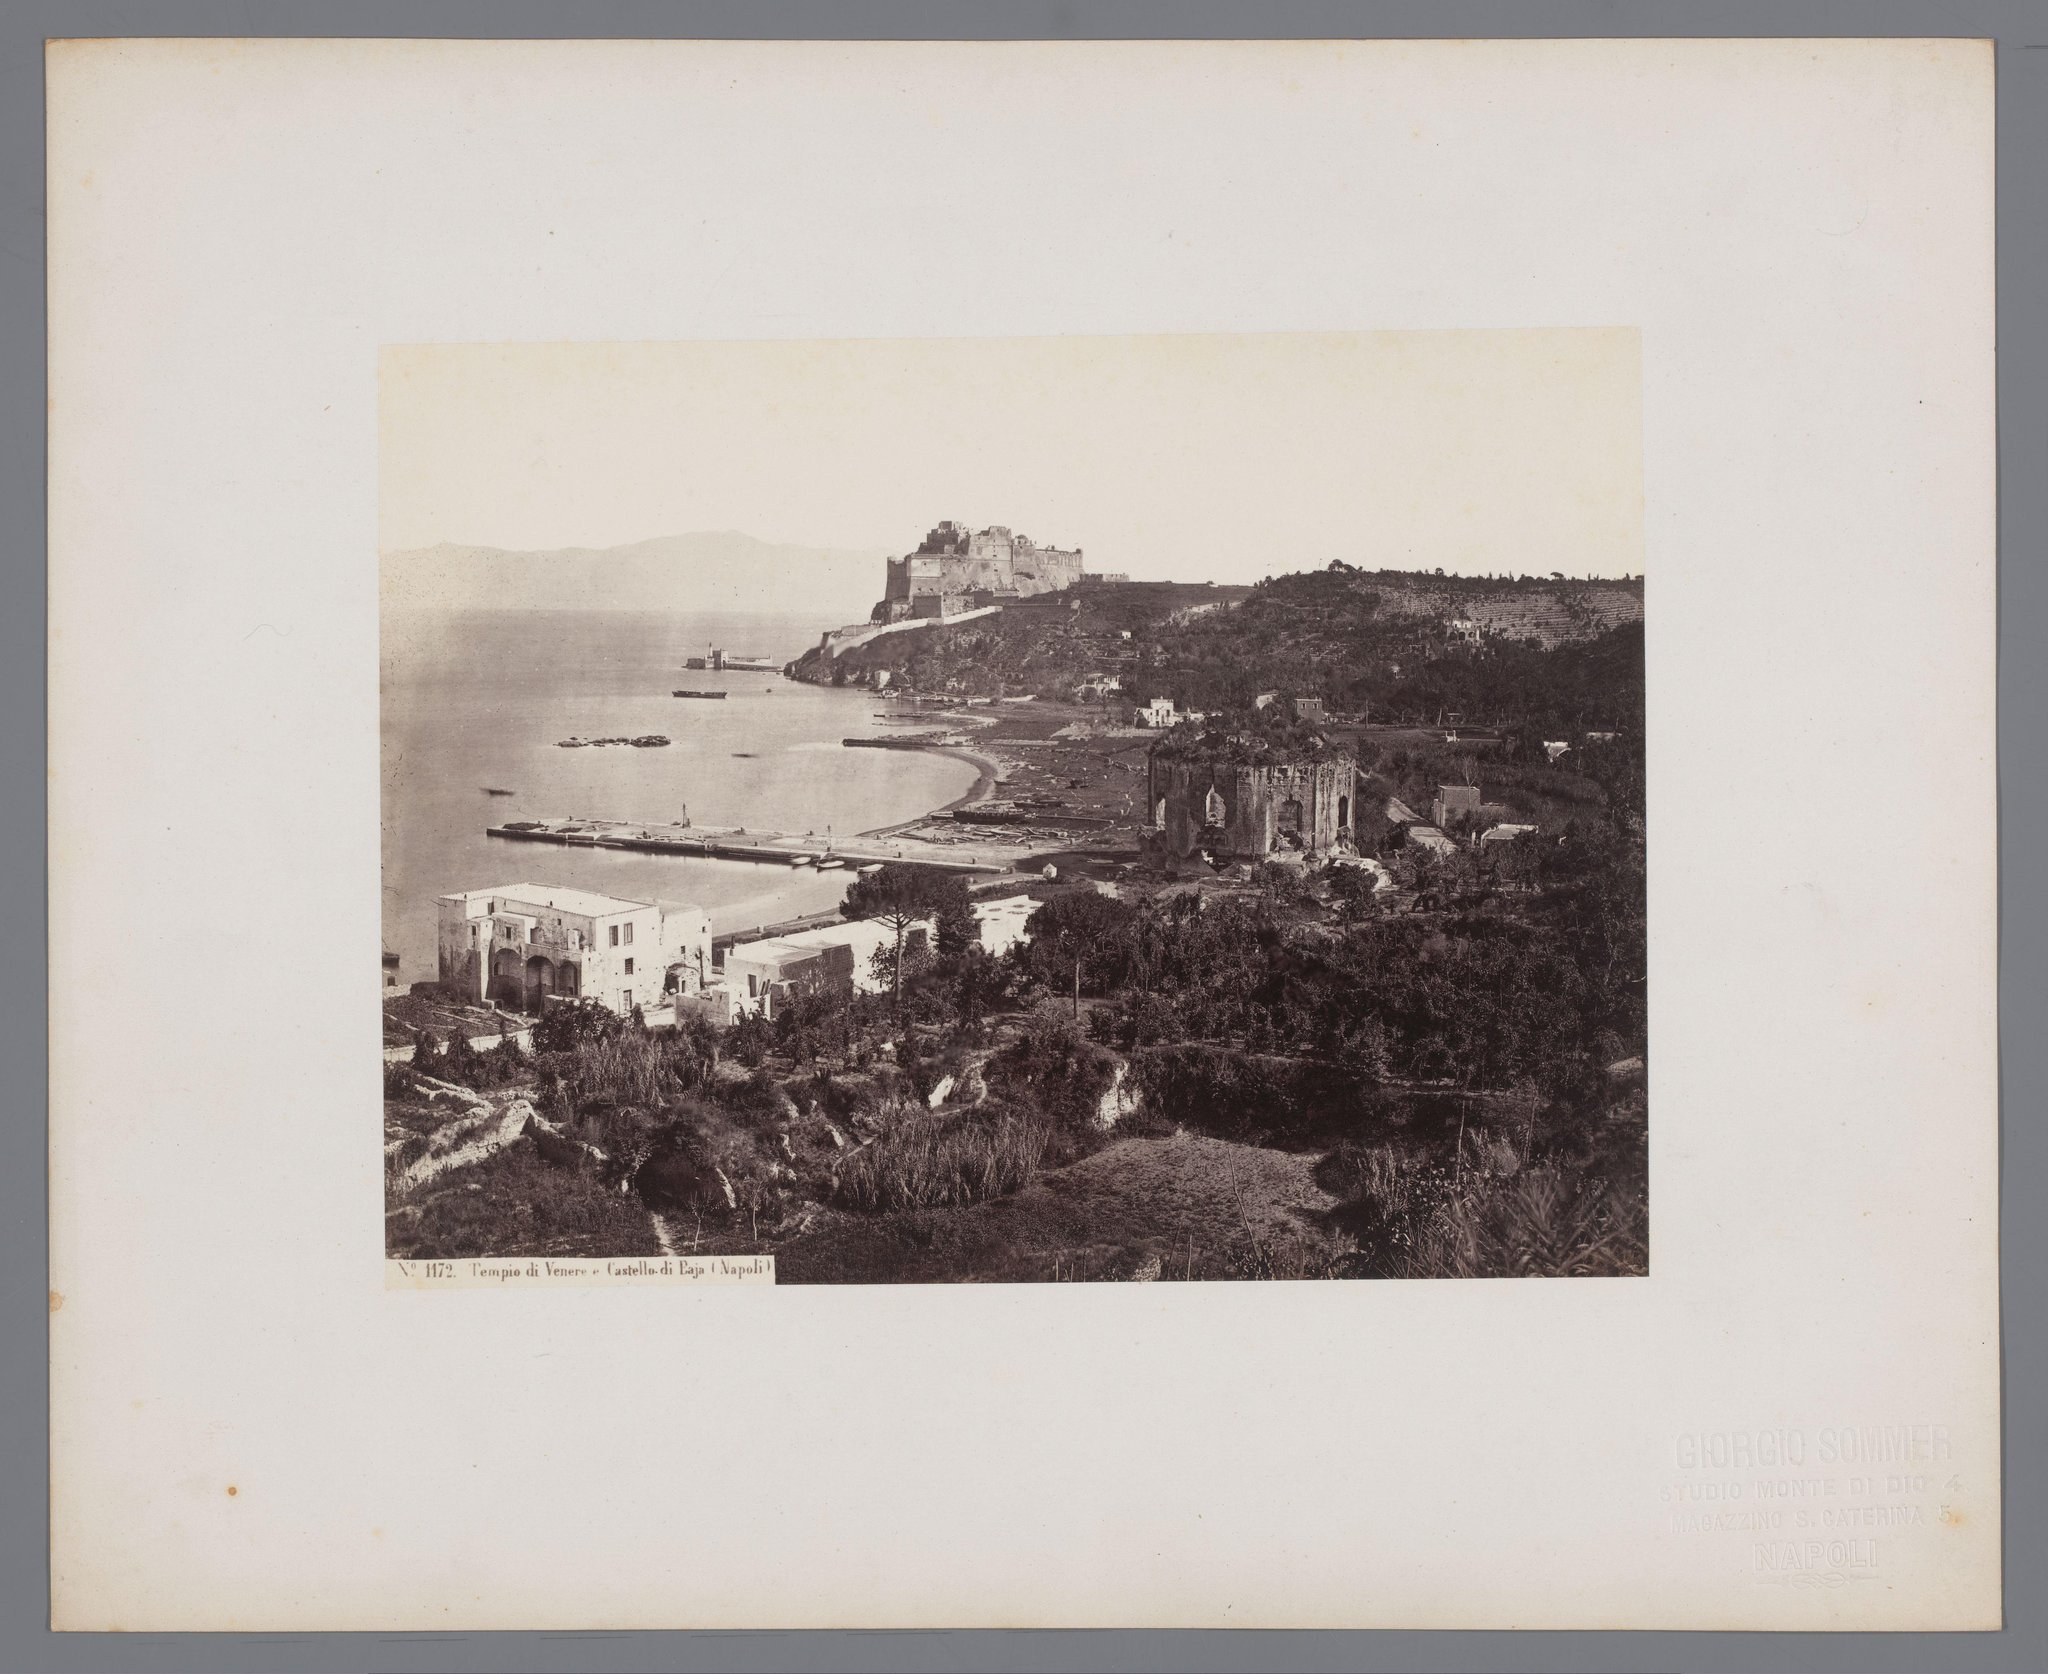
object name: photograph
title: Gezicht op de baai van Napels, Italië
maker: giorgio sommer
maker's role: fotograaf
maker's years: 1834-1914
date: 1857-1914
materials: cardboard, paper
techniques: albumen print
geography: naples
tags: gulf, bay, fortress, ruin of a building ~ architecture, naples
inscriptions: number: ‘No. 1172.’, address: ‘GIORGIO SOMMER/ STUDIO MONTE DI DIO 4./ MAGAZZINO S. CATERINA 5./ NAPOLI’